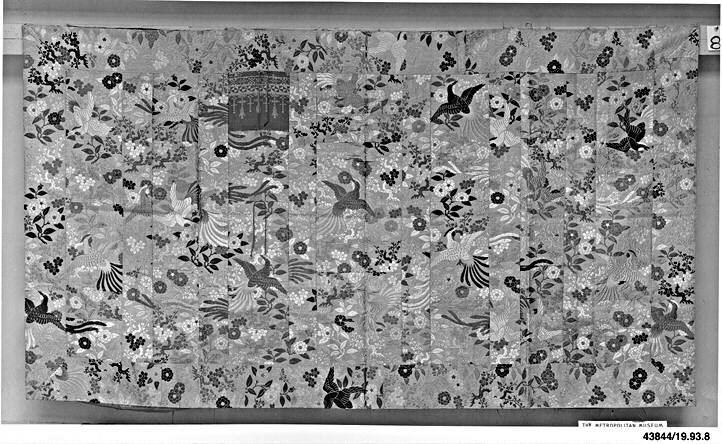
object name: robe, priest's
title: Priest's Robe (Shichijō)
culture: japanese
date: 1624-1644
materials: silk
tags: birds